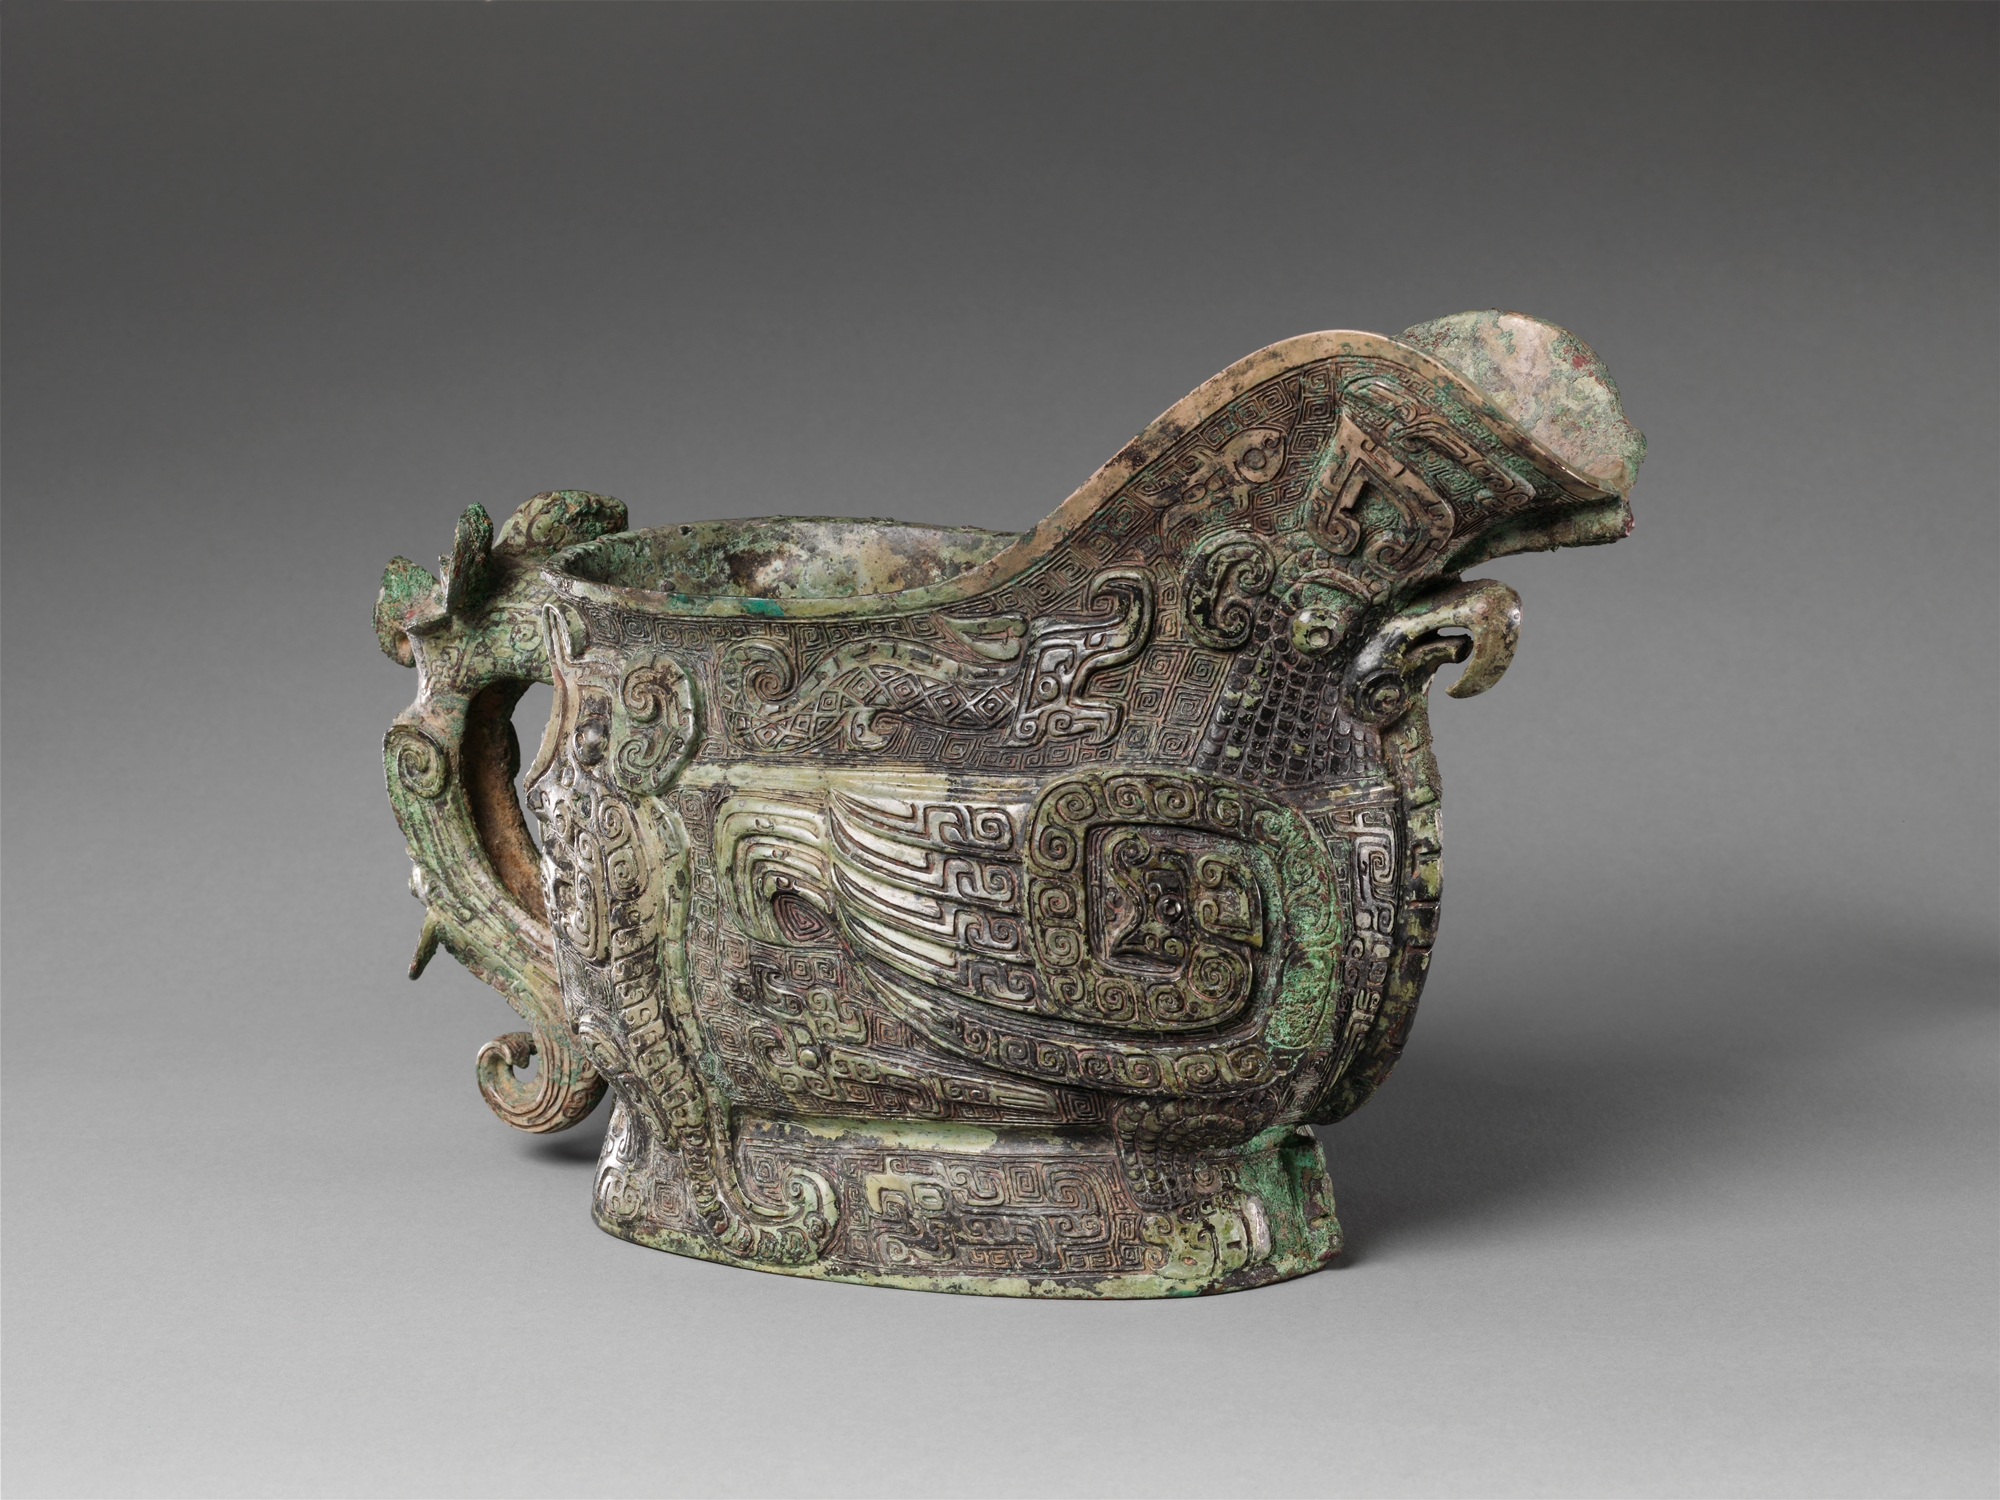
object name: wine vessel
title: Wine pouring vessel (Gong)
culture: chinese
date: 1300-1001 BCE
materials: bronze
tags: dragons,fish